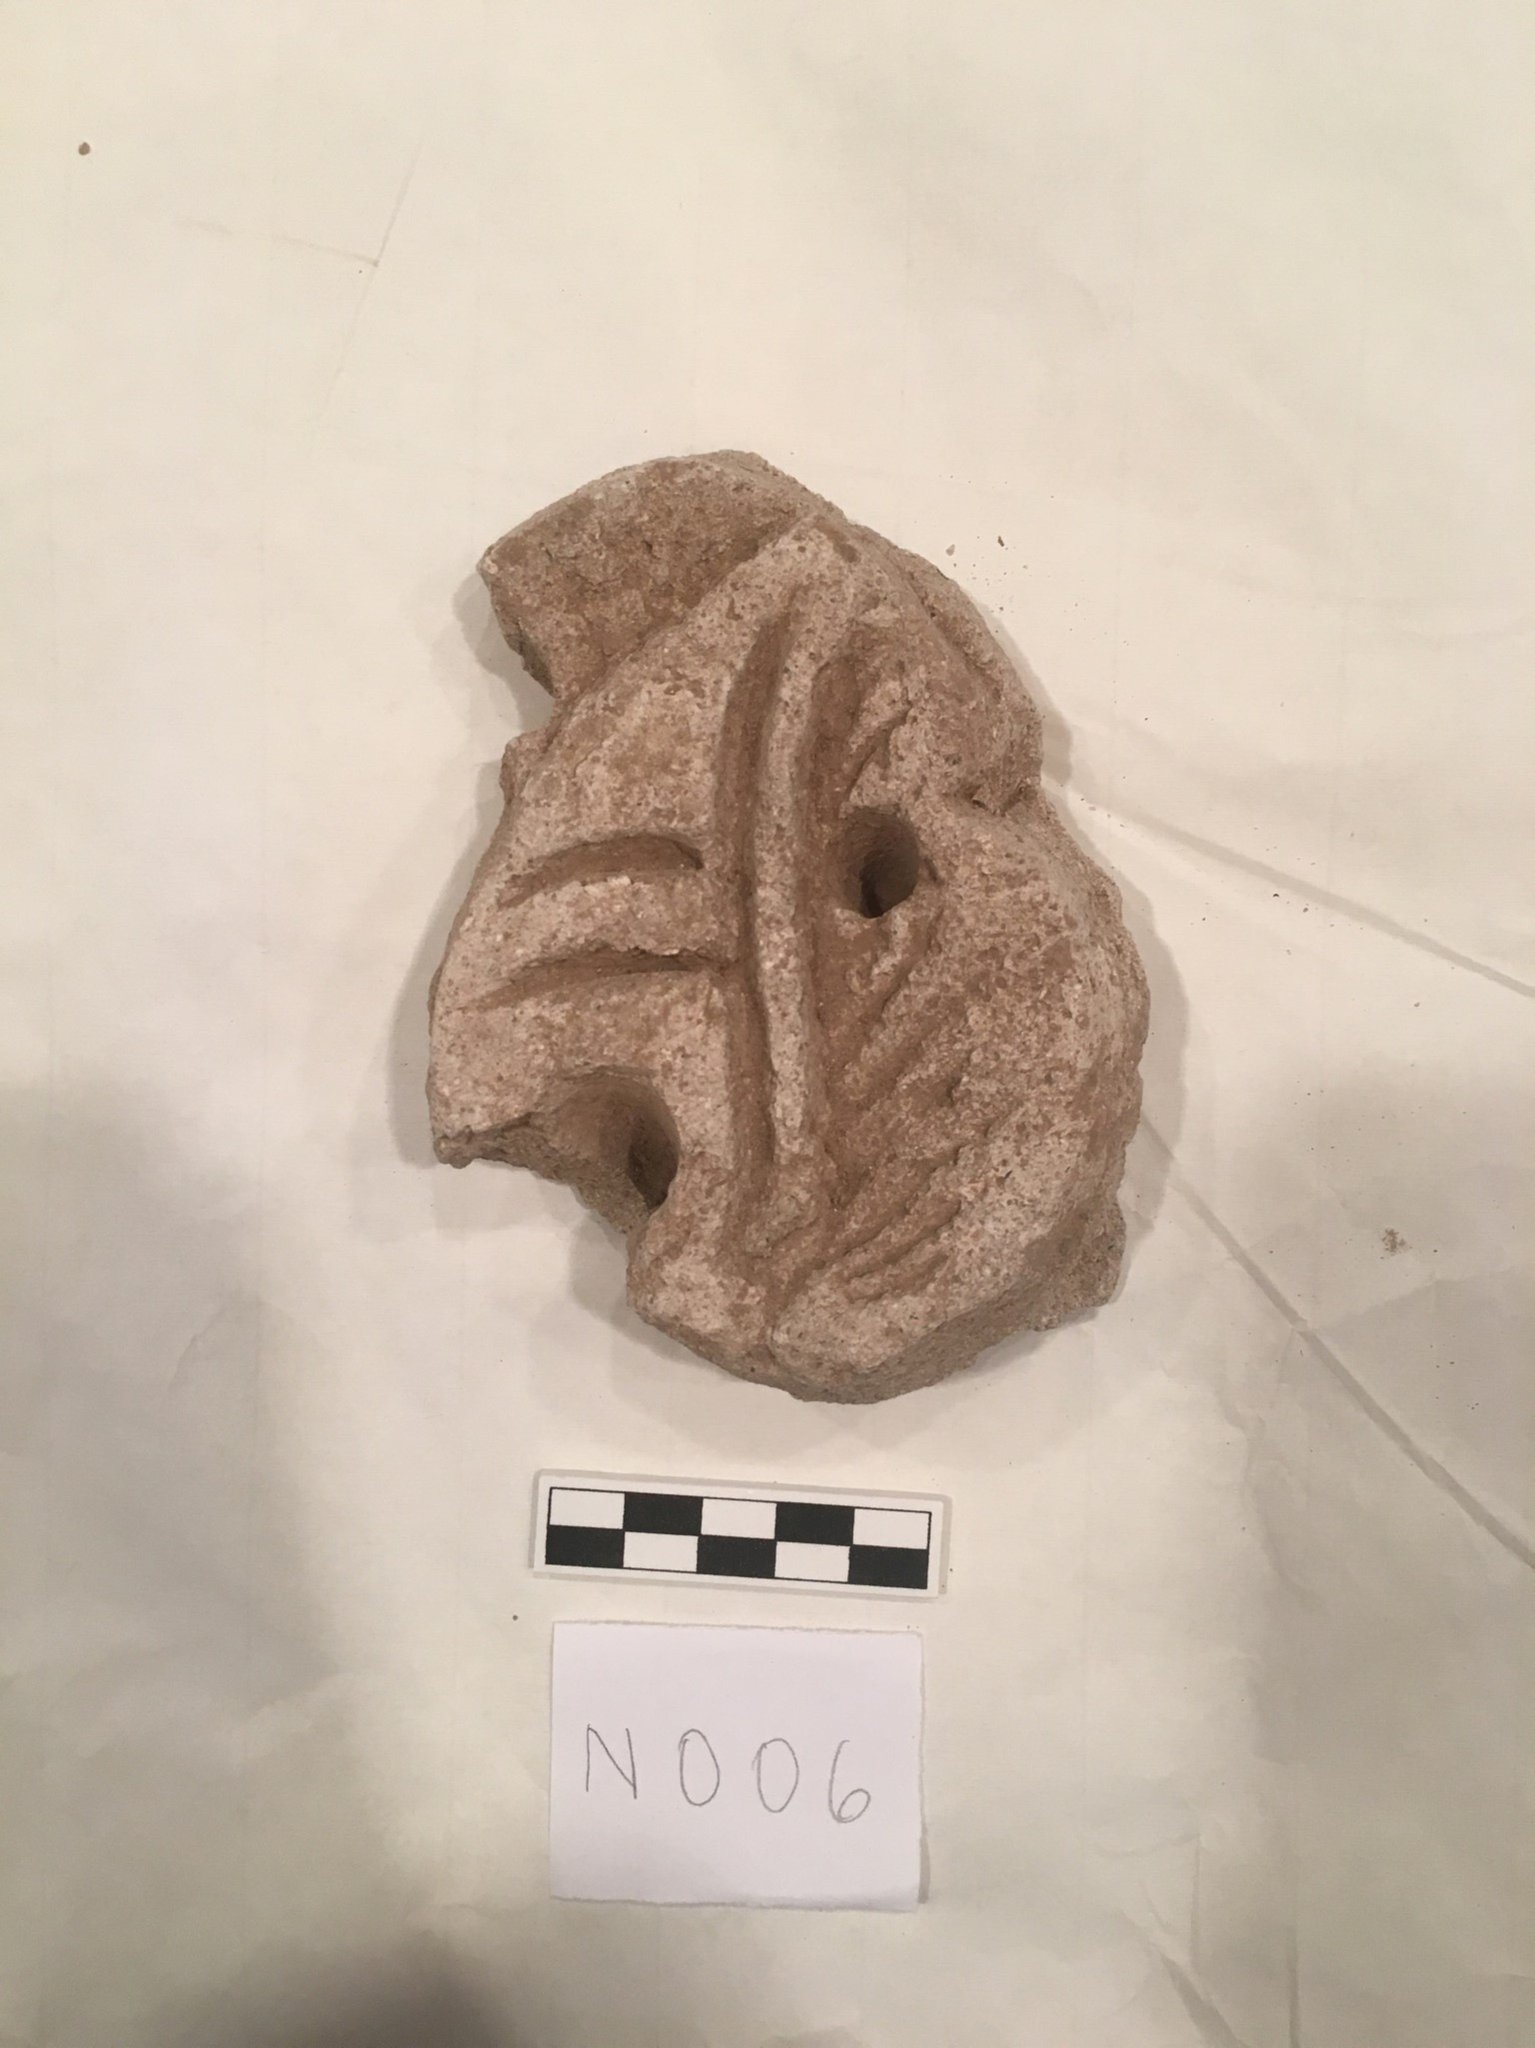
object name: fragment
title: Stucco Fragment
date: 701-1200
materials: plaster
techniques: carving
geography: iran